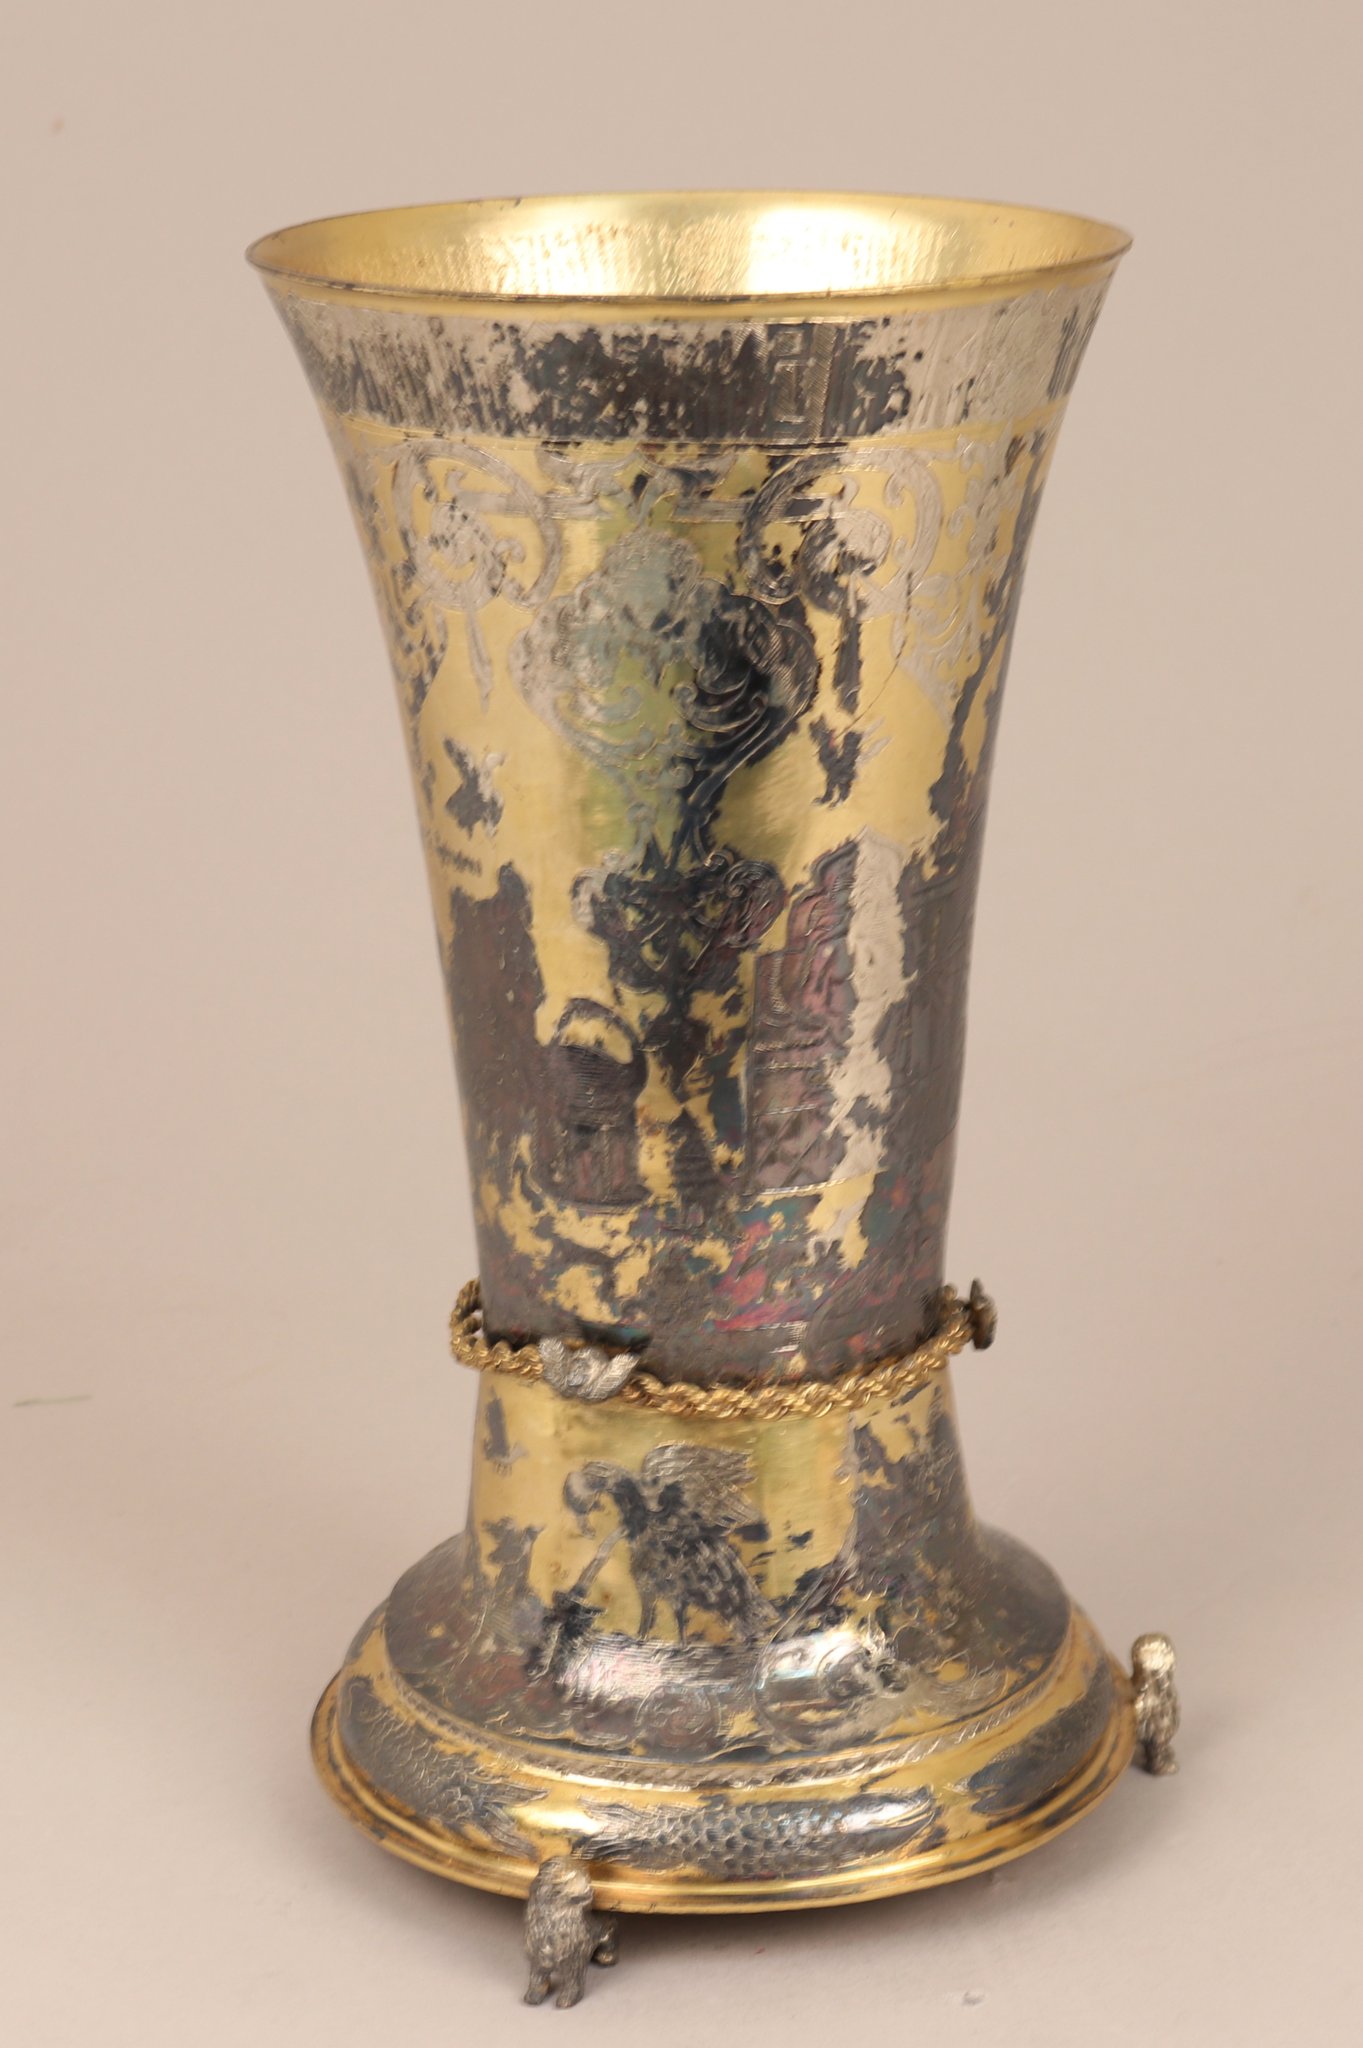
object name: beaker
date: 1801-1900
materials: gilt, silver